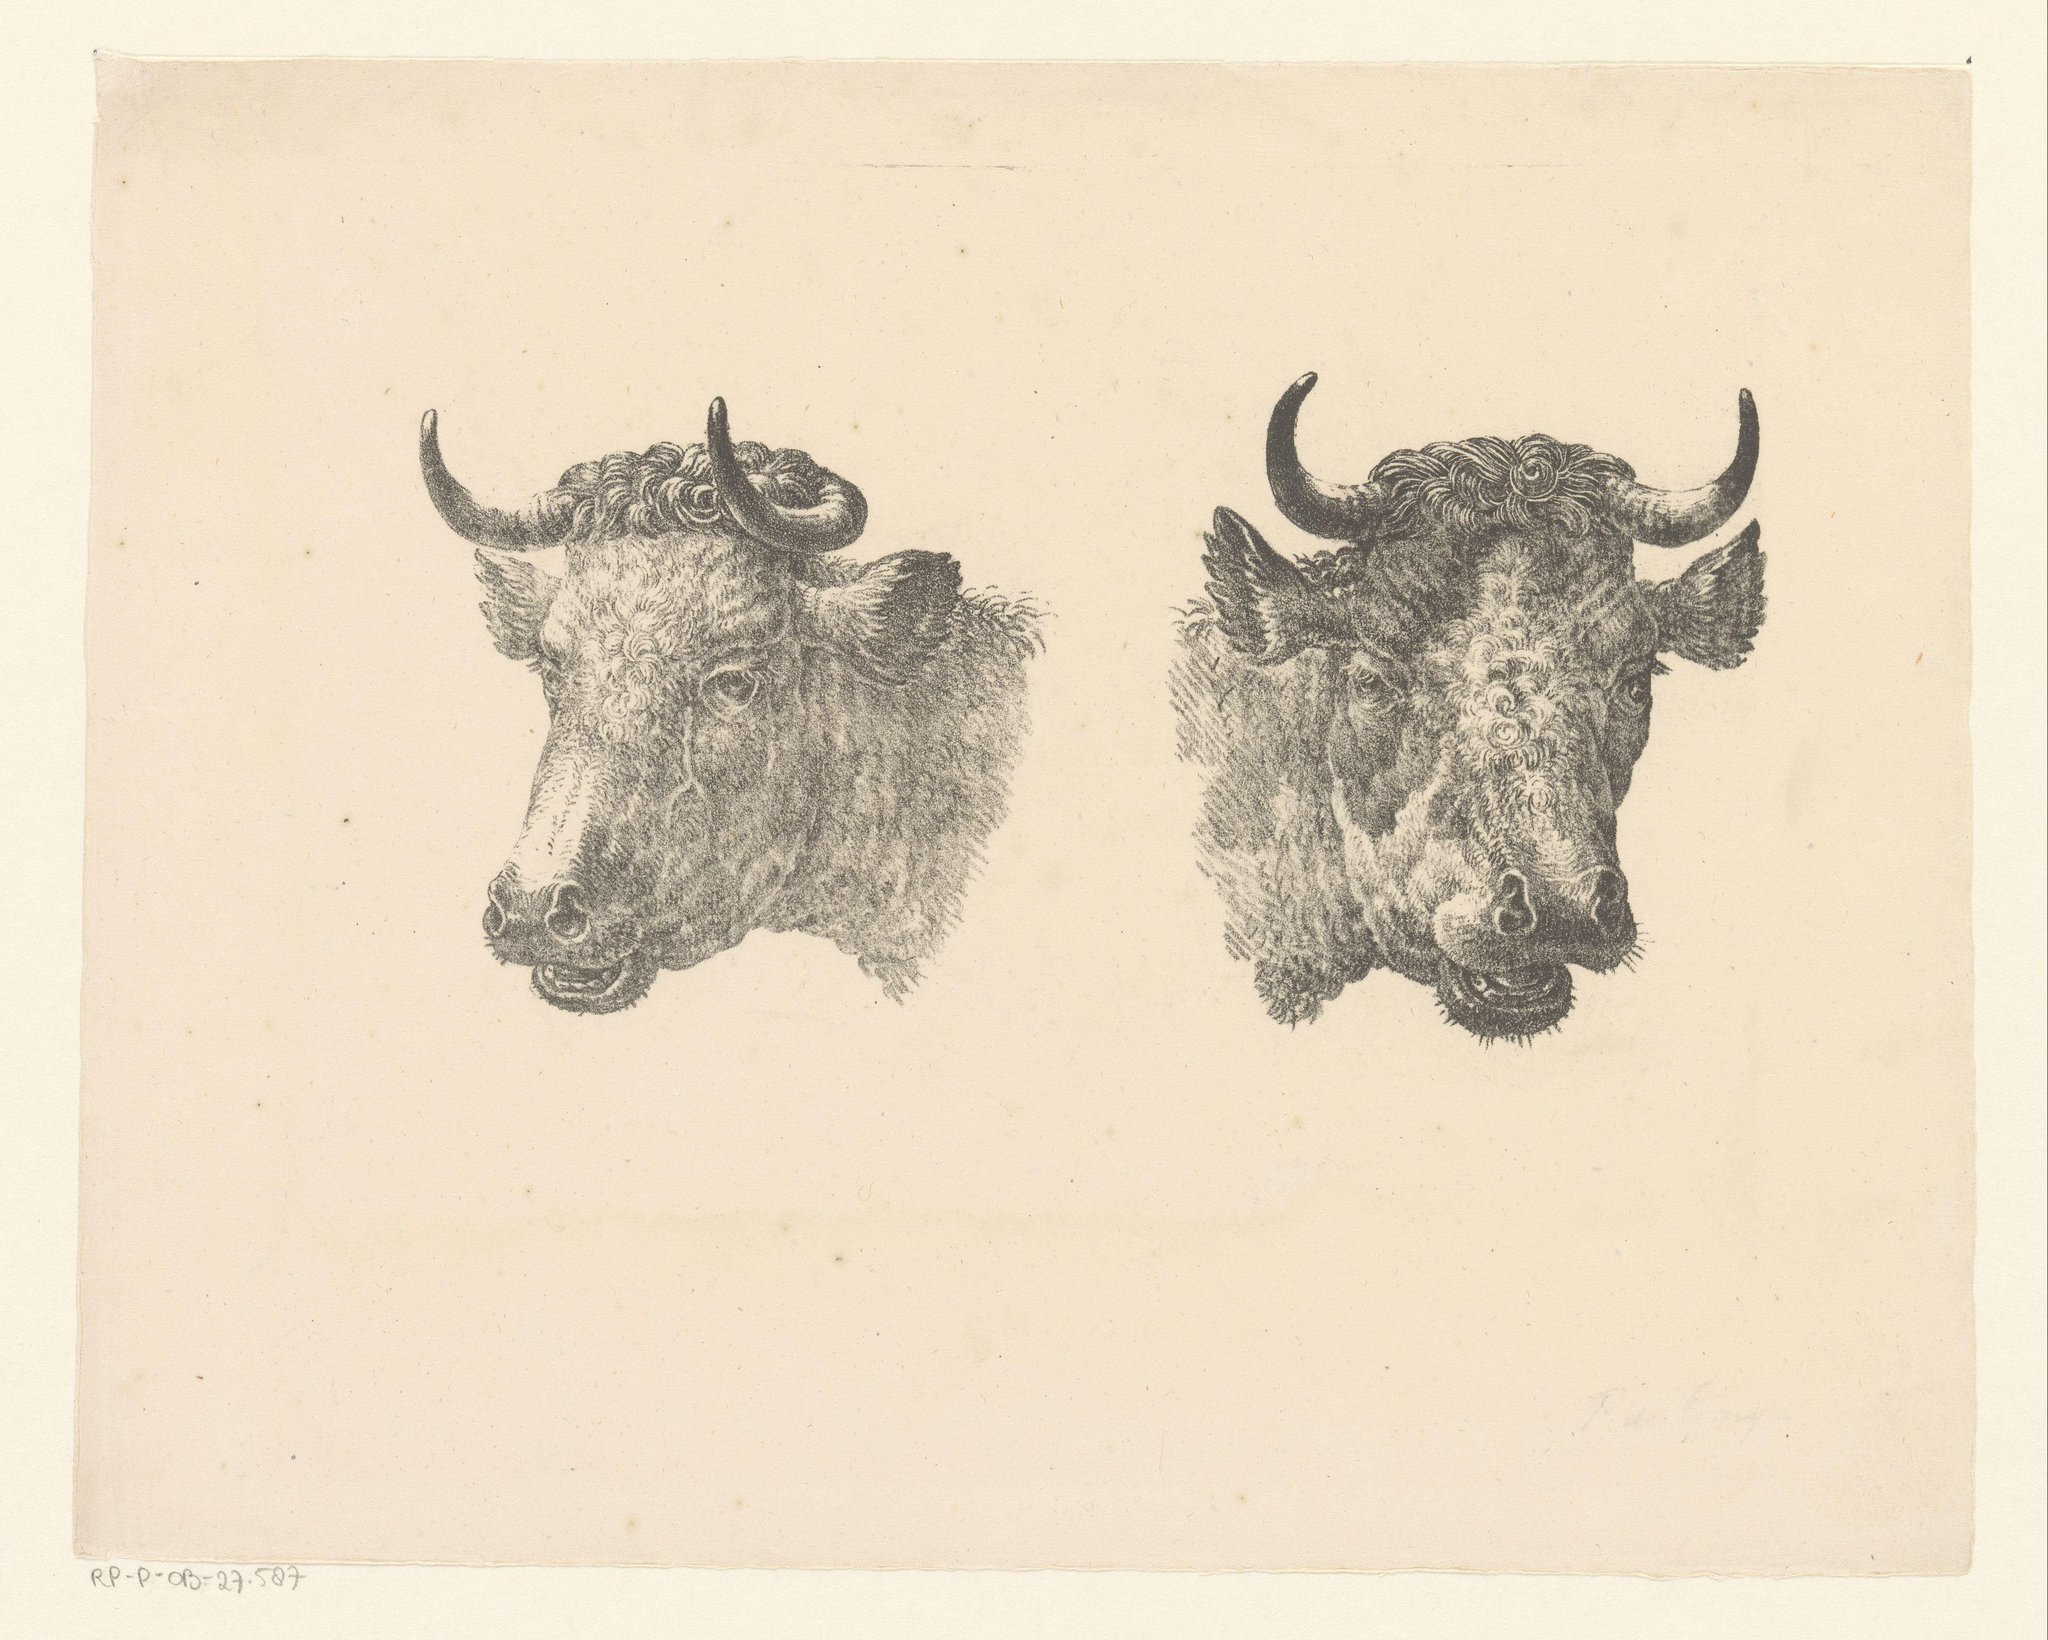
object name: print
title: Twee stierenkoppen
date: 1809-1837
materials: paper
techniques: lithograph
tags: bull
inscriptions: collector's mark: Lugt 2228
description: De stieren hebben hun bek open. De linker stier is van opzij gezien, de rechter stier frontaal.